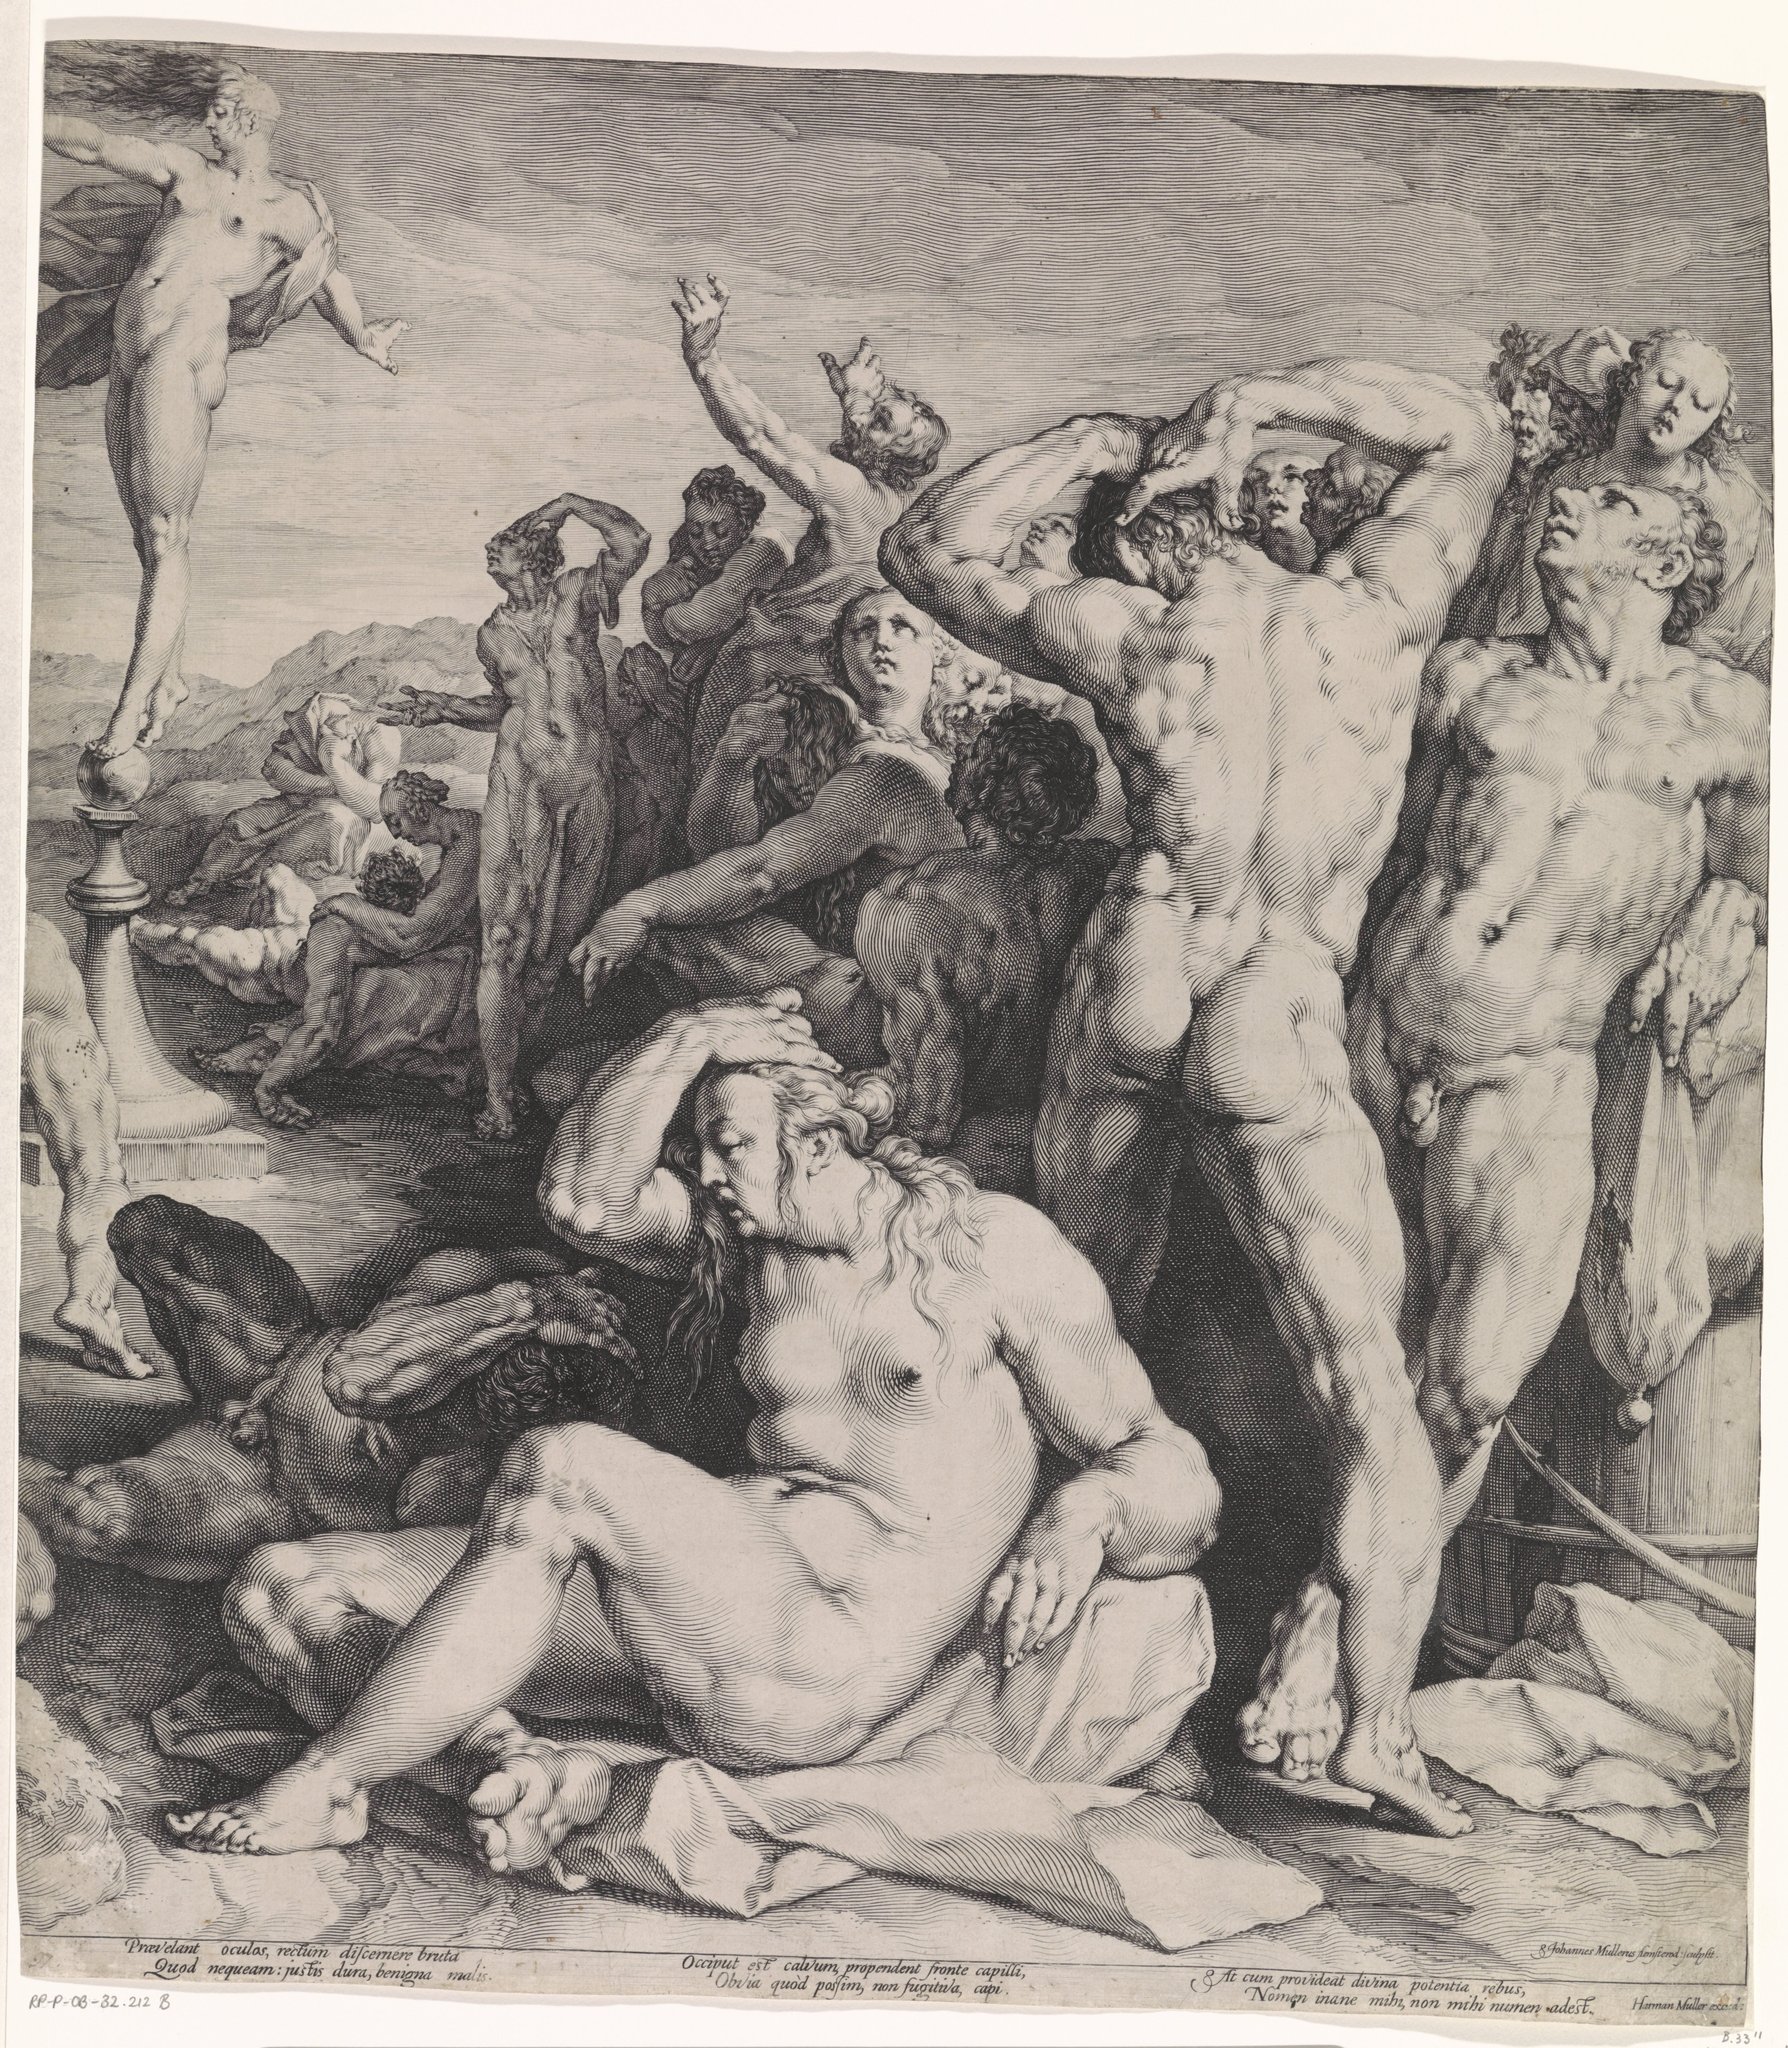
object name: print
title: Fortuna verdeelt haar geschenken (rechter blad)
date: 1590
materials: paper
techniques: engraving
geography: amsterdam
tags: luck, fortune, lot; 'fato', 'fortuna', 'fortuna aurea', 'fortuna buona', 'fortuna pacifica overo clemente', 'sorte' (ripa)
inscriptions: collector's mark: Lugt 2228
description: De naakte godin Fortuna deelt, staande op een globe, haar geschenken uit. Ze staat echter met haar rug naar de mensen, die niks ontvangen. Zij zitten en staan letterlijk met de handen in het haar. Onderaan in de marge drie tweeregelige verzen in Latijn.